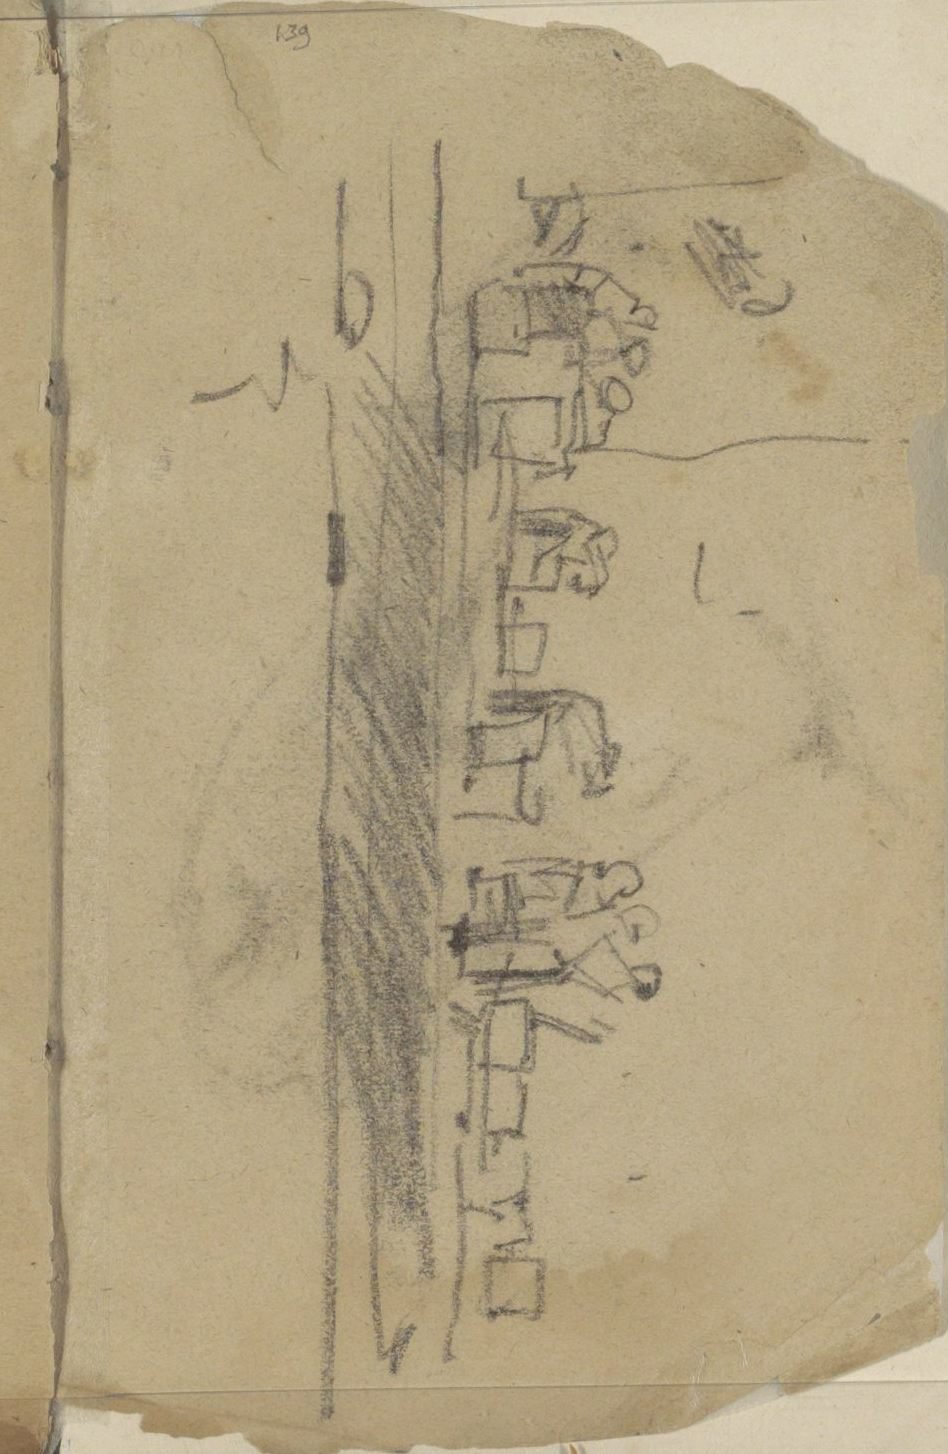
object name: sketchbook leaf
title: Figuren aan het werk, mogelijk wasvrouwen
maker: george hendrik breitner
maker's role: draughtsman, painter, print maker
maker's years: 1857-1923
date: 1881-1883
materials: chalk, paper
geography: south holland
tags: adult woman, laundering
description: Figuren aan het werk, mogelijk wasvrouwen. Pagina 139 uit een schetsboek met 70 bladen.